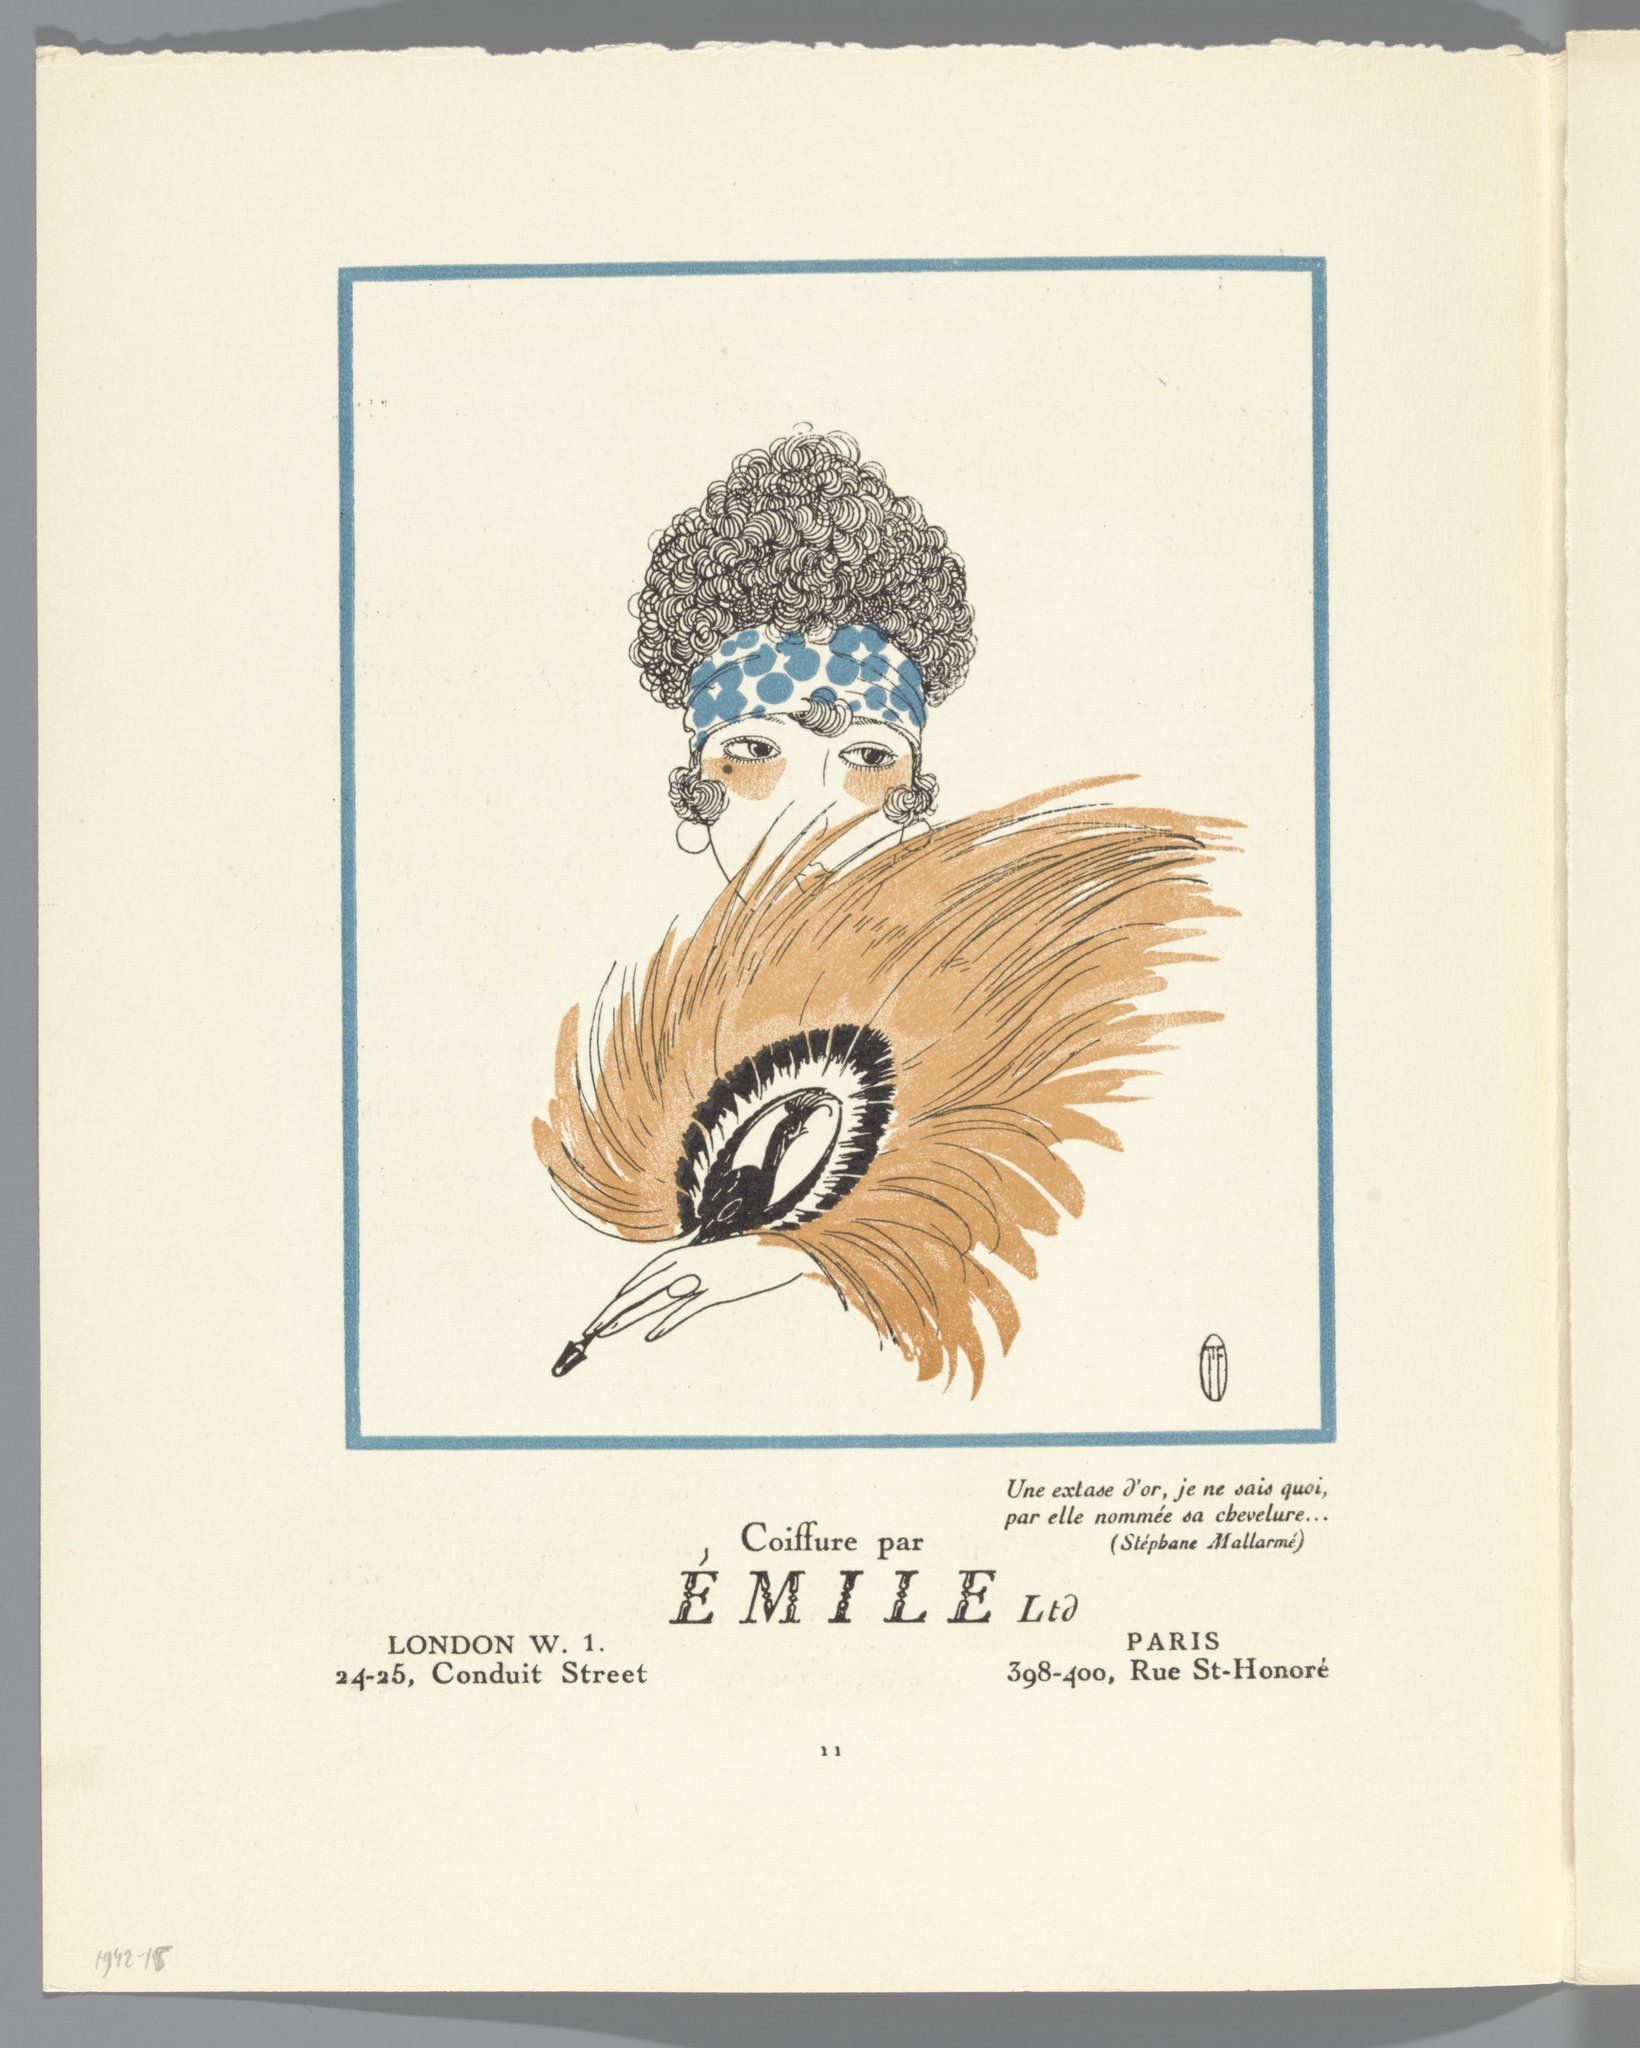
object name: fashion print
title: Gazette du Bon Ton. Art – Modes & Frivolités: Advertising Material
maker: lucien vogel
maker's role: publisher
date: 1920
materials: paper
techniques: hand coloring, letterpress printing, lithograph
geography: new york city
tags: styles of hairdress - aa - ~ women, fashion plates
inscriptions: date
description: The Gazette du Bon Ton also included advertisements: for shops selling fashions and fabrics, jewellers, hairdressers and beauticians. These ads were also well designed; many were drawn by the same artists who supplied the fashion plates. Even the smallest ads were presented with flair and in a style that was befitting of the whole.